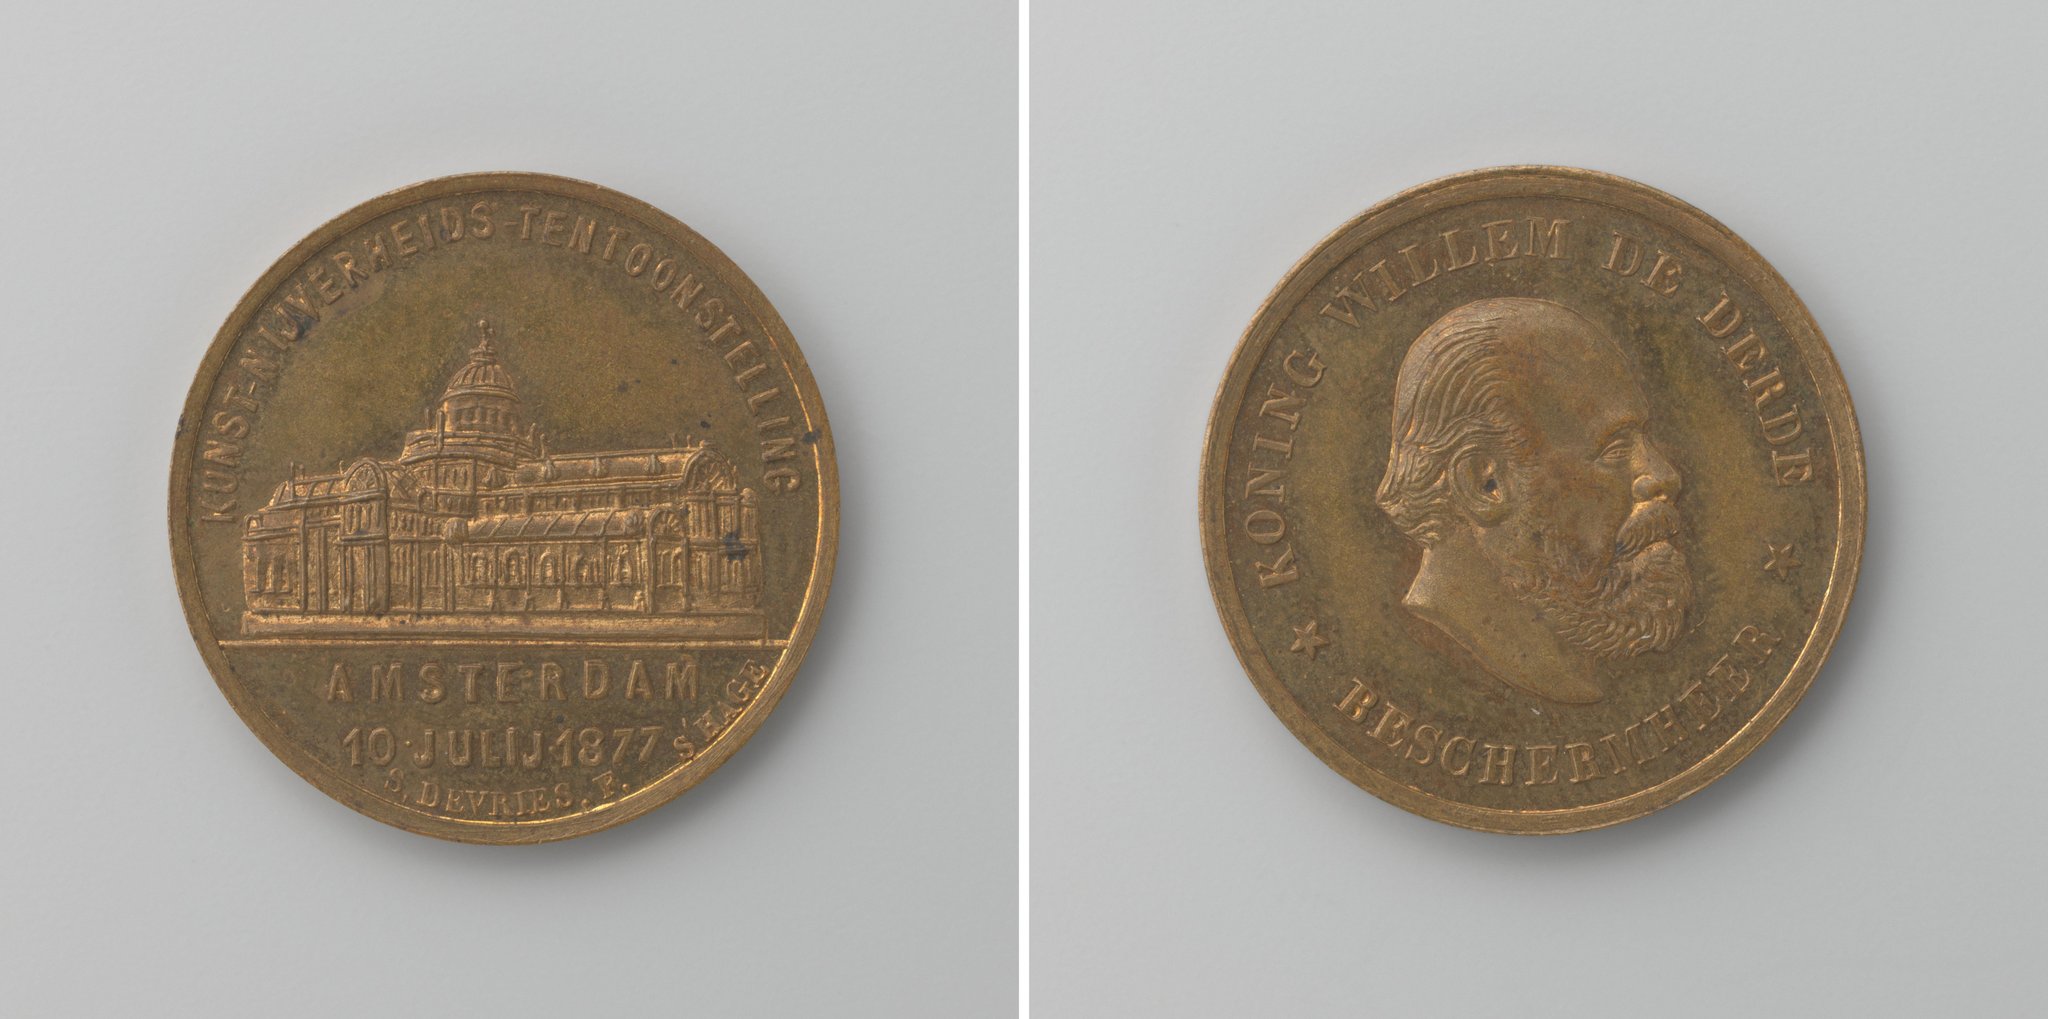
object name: history medal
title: Internationale tentoonstelling van kunstnijverheid te Amsterdam 1877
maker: salomon de vries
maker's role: graveur, medailleur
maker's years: 1830-1899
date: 1877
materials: brass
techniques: striking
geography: the hague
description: Messing penning, op de voorzijde het portret van Koning Willem III naar rechts met omschrift, op de keerzijde het aanzicht van het Paleis van Volksvlijt met omschrift en afsnedetekst.